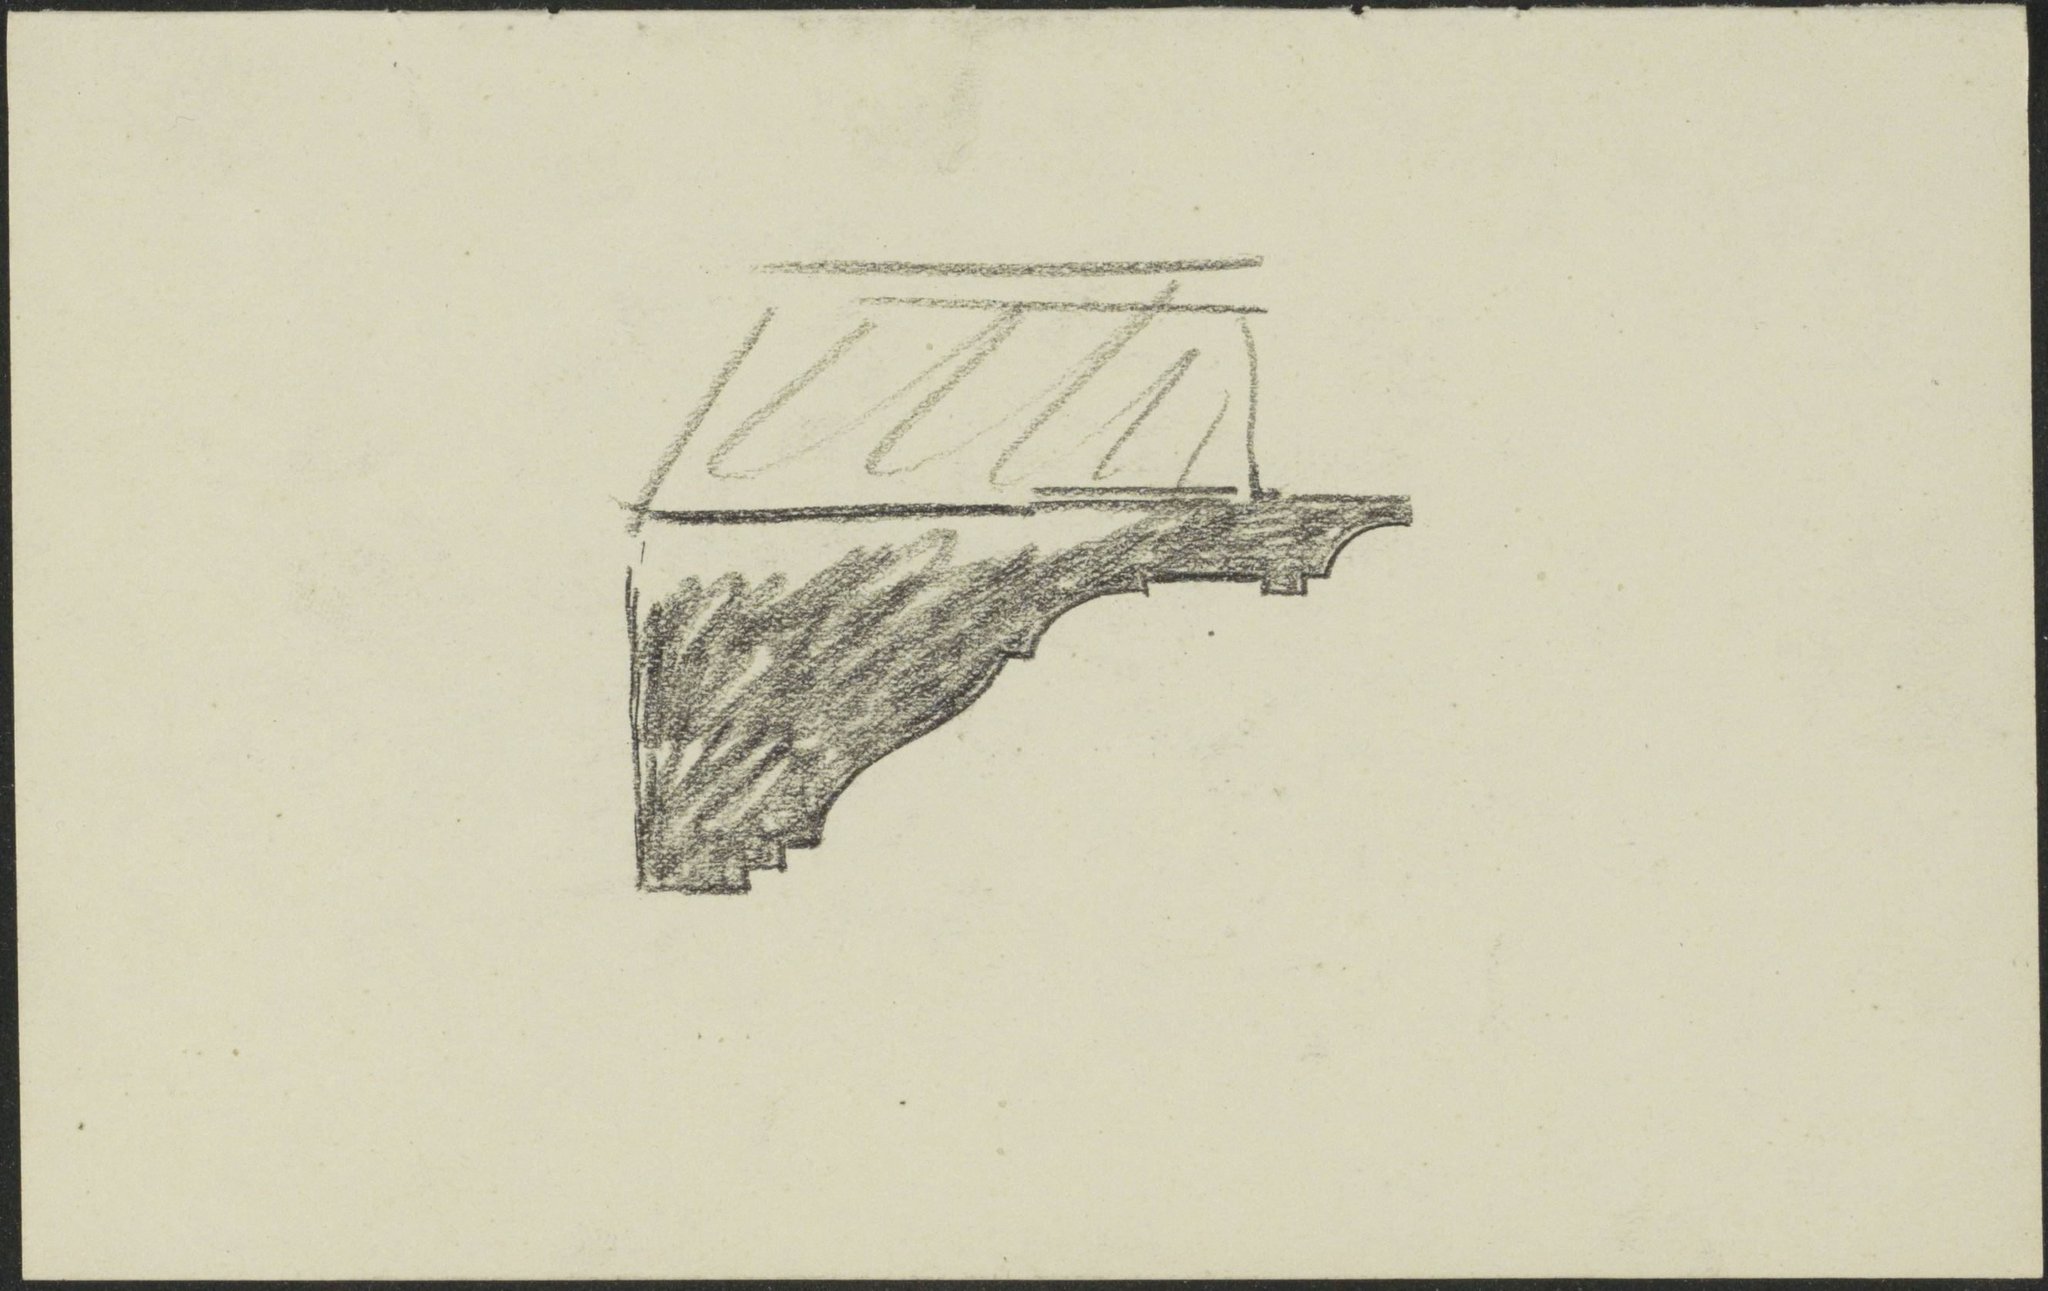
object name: drawing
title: Console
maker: gerrit willem dijsselhof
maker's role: designer, draughtsman, print maker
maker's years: 1866-1924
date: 1876-1924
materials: chalk, paper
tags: architectural detail